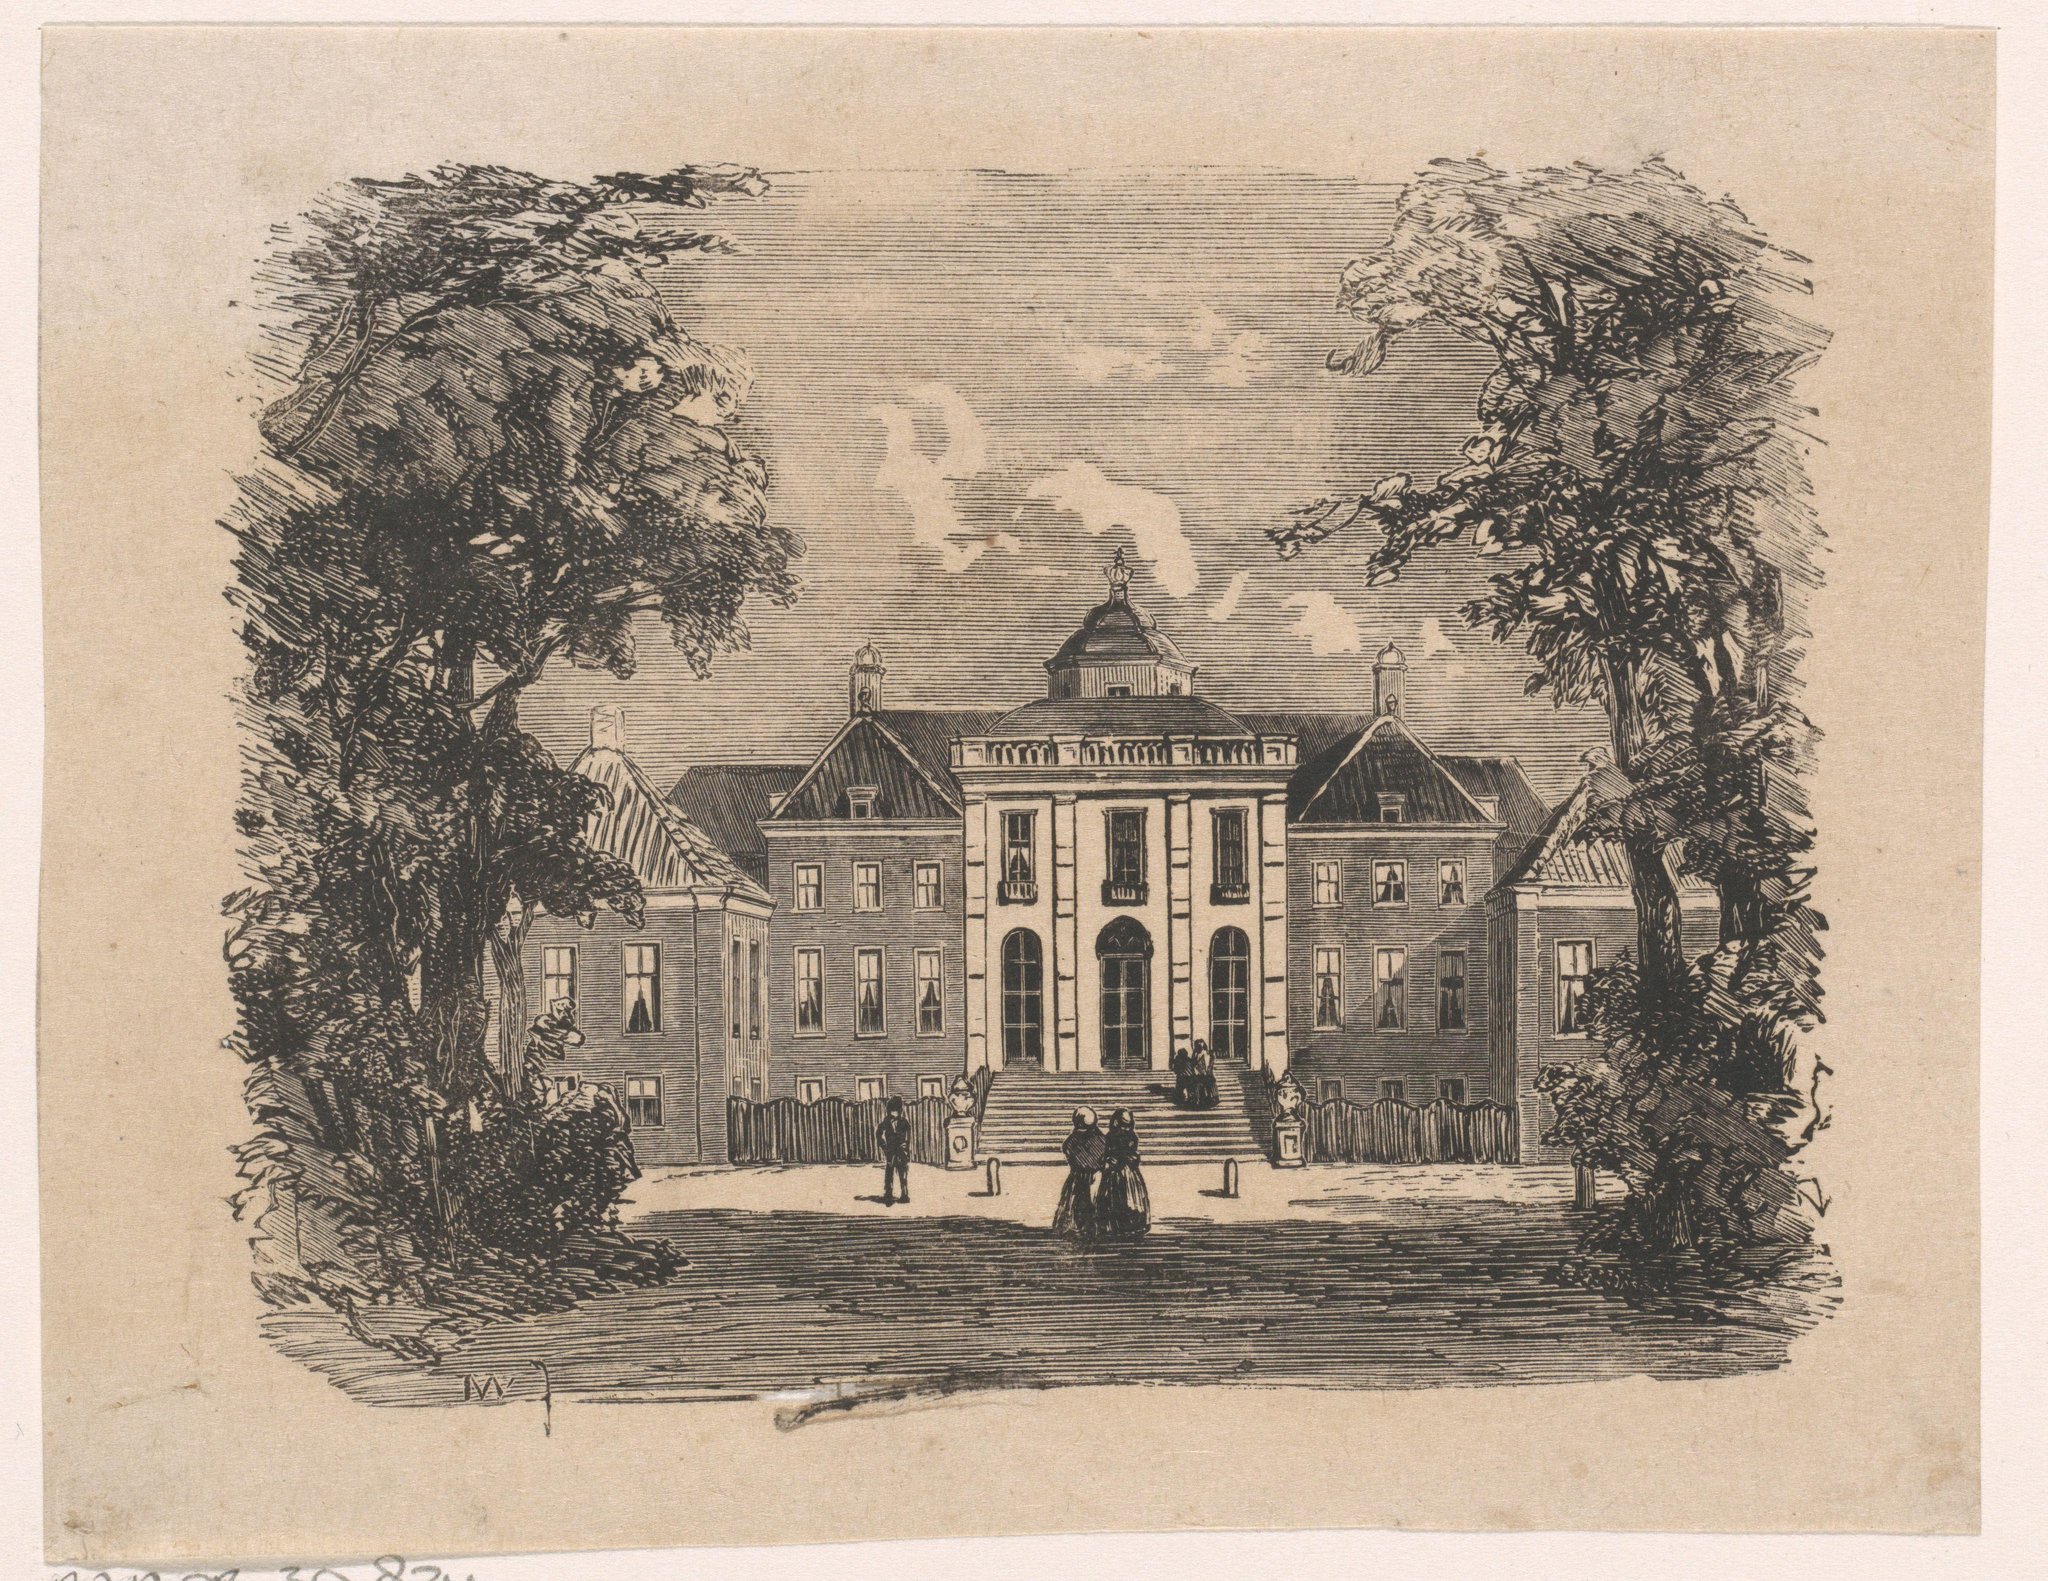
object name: print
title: Gezicht op Huis ten Bosch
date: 1836-1912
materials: paper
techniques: engraving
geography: netherlands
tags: paleis huis ten bosch